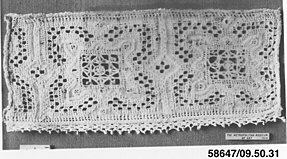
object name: strip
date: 1801-1900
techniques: embroidery